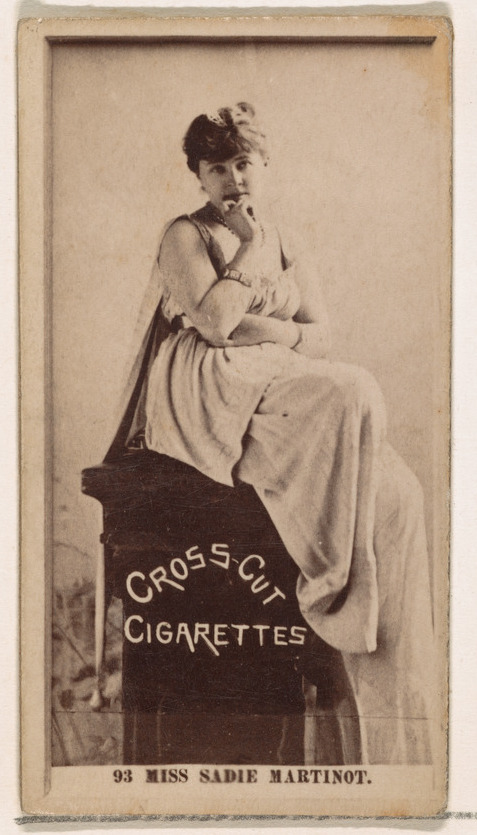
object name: print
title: Card Number 93, Miss Sadie Martinot, from the Actors and Actresses series (N145-2) issued by Duke Sons & Co. to promote Cross Cut Cigarettes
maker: w. duke, sons & co.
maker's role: publisher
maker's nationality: american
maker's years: 1870-1920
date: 1880-1889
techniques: albumen silver print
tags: portraits,women,actresses